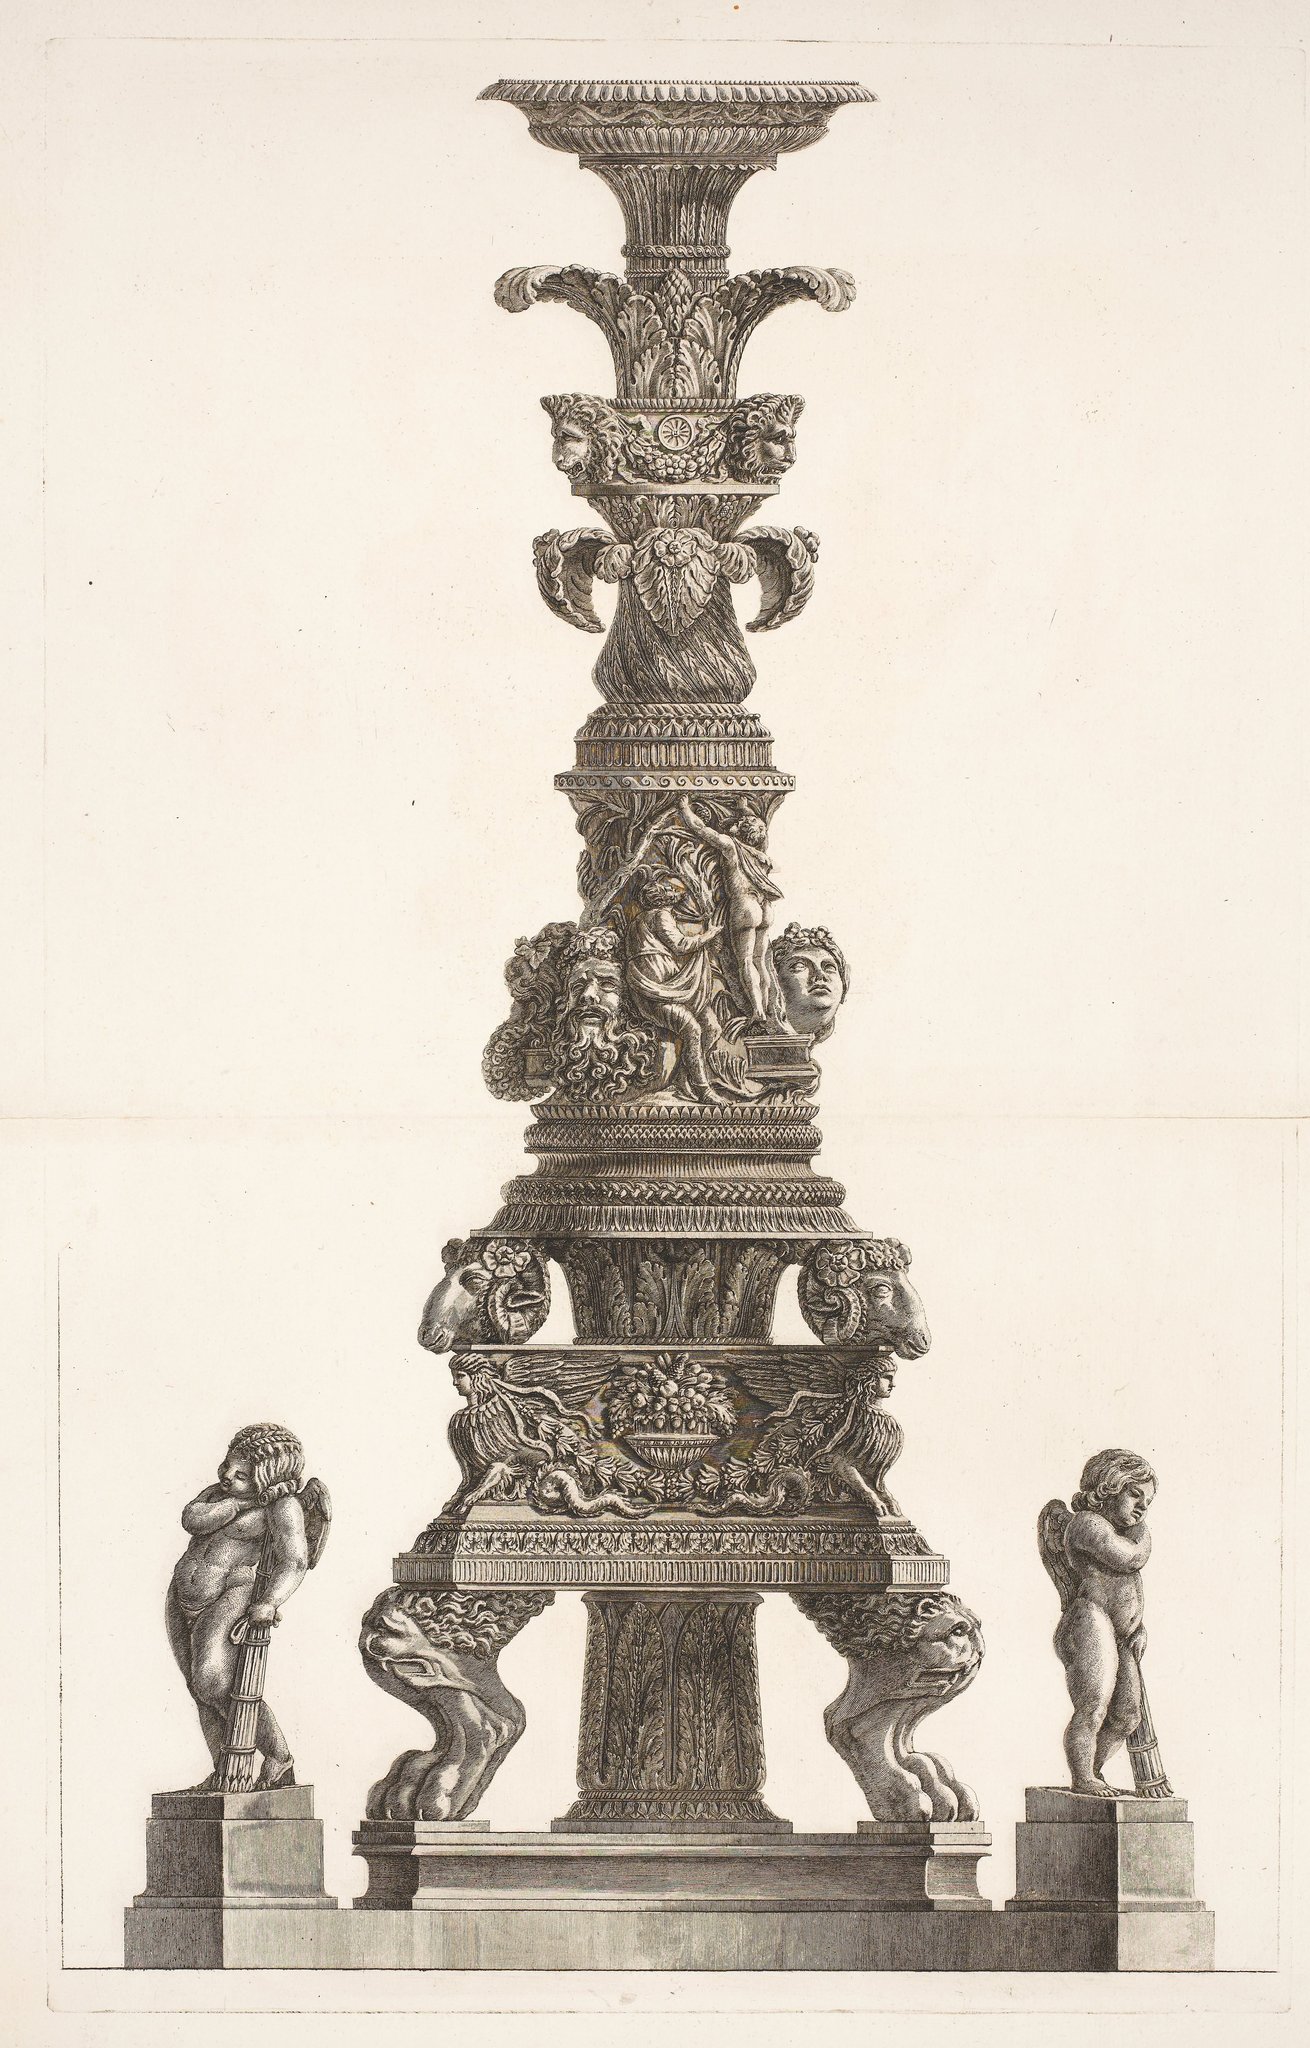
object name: print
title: Kandelaber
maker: giovanni battista piranesi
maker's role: designer, draughtsman, print maker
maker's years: 1720-1778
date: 1778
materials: paper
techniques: etching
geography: rome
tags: chandelier, candelabrum, cupids: 'amores', 'amoretti', 'putti'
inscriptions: collector's mark: Lugt 2228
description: De 'Vasi'-reeks telt 110 prenten, verspreid over twee volumes met elk een eigen titelprent. Piranesi werd voor deze reeks geholpen door verschillende assistenten uit zijn werkplaats, waaronder zijn zoon Francesco die ook nog eens 8 platen toevoegde aan de reeks in 1779-1780.